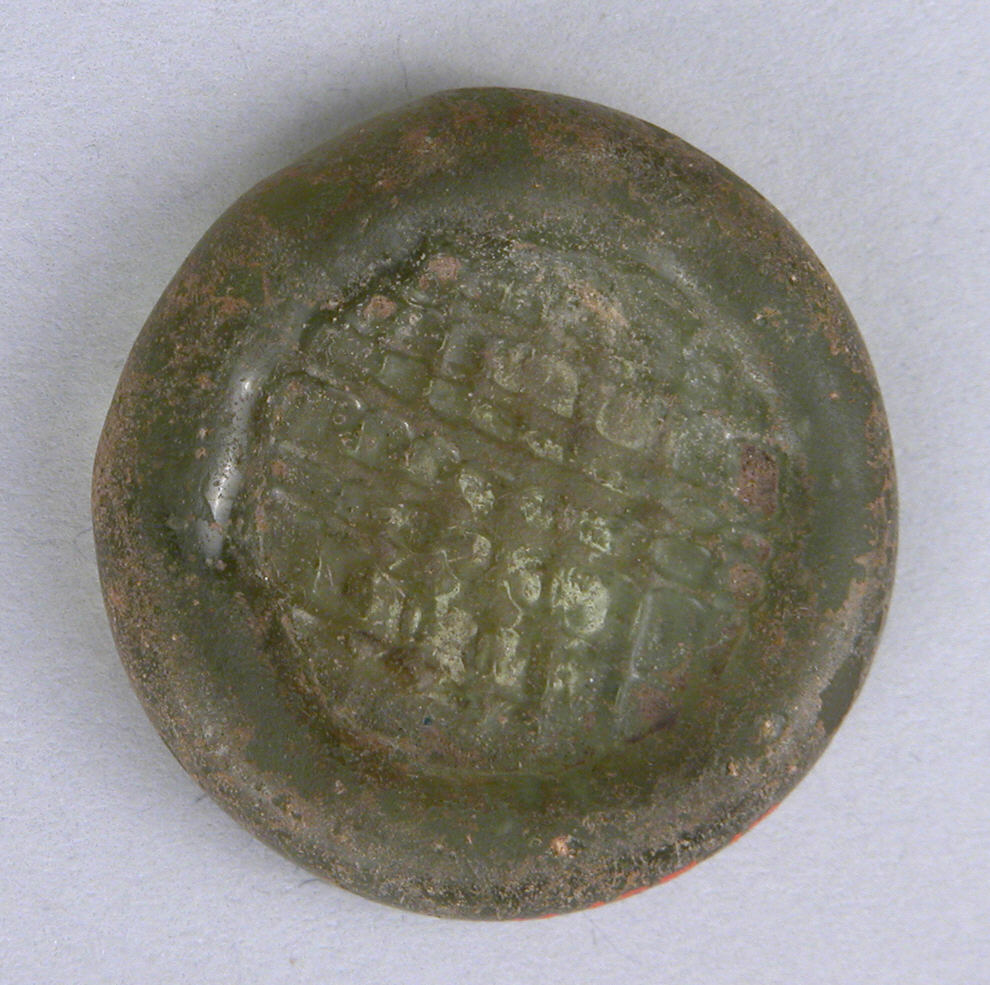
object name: coin weight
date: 1101-1400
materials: glass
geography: egypt